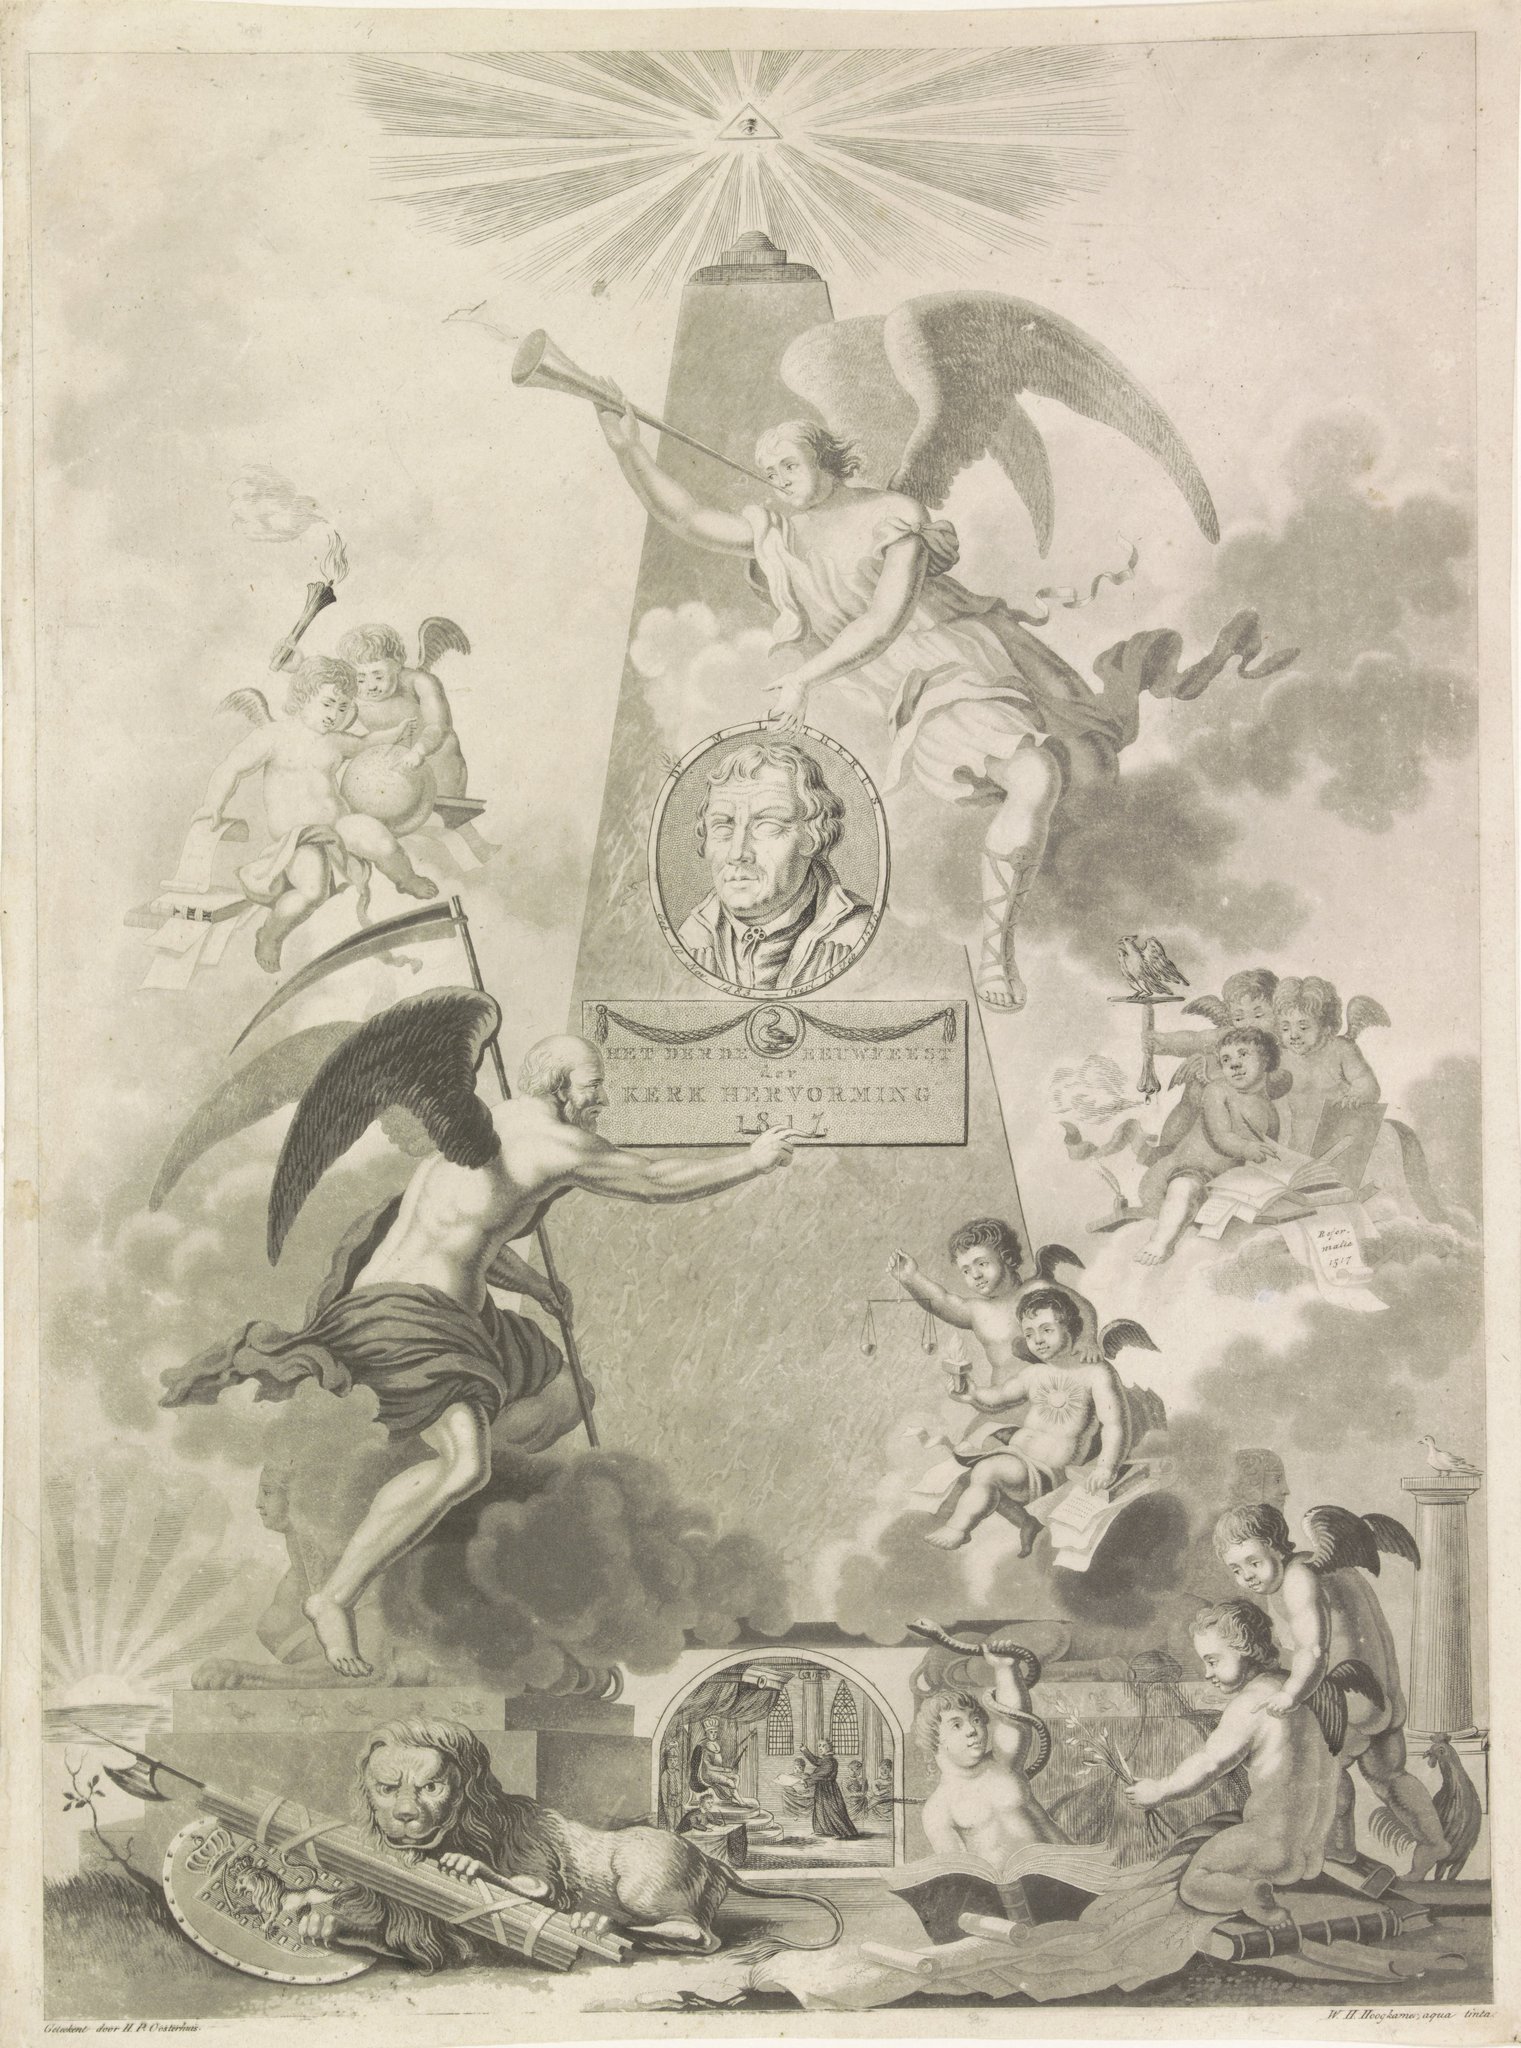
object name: print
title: Het Derde Eeuwfeest der Kerk Hervorming 1817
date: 1814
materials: paper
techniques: aquatint, engraving, etching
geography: netherlands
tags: martin luther, monument, statue, the all-seeing eye, triangle with eye ~ symbol of god the father, fame; 'fama', 'fama buona', 'fama chiara' (ripa), father time, man with wings and scythe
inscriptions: collector's mark: Lugt 2228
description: Monument voor het derde eeuwfeest van de Hervorming, 1517-1817. Allegorische voorstelling met centraal een piramide met een portret van Martin Luther. Hierbij de Faam die op haar bazuin blaast. Vader Tijd schrijft het opschrift op de piramide. Boven de piramide het Alziende Oog. Links en rechts putti in de wolken met boeken. Onderaan Luther die zijn stellingen verdedigt op de Rijksdag in Worms (1521). Links de Nederlandse leeuw met pijlenbundel en wapen.